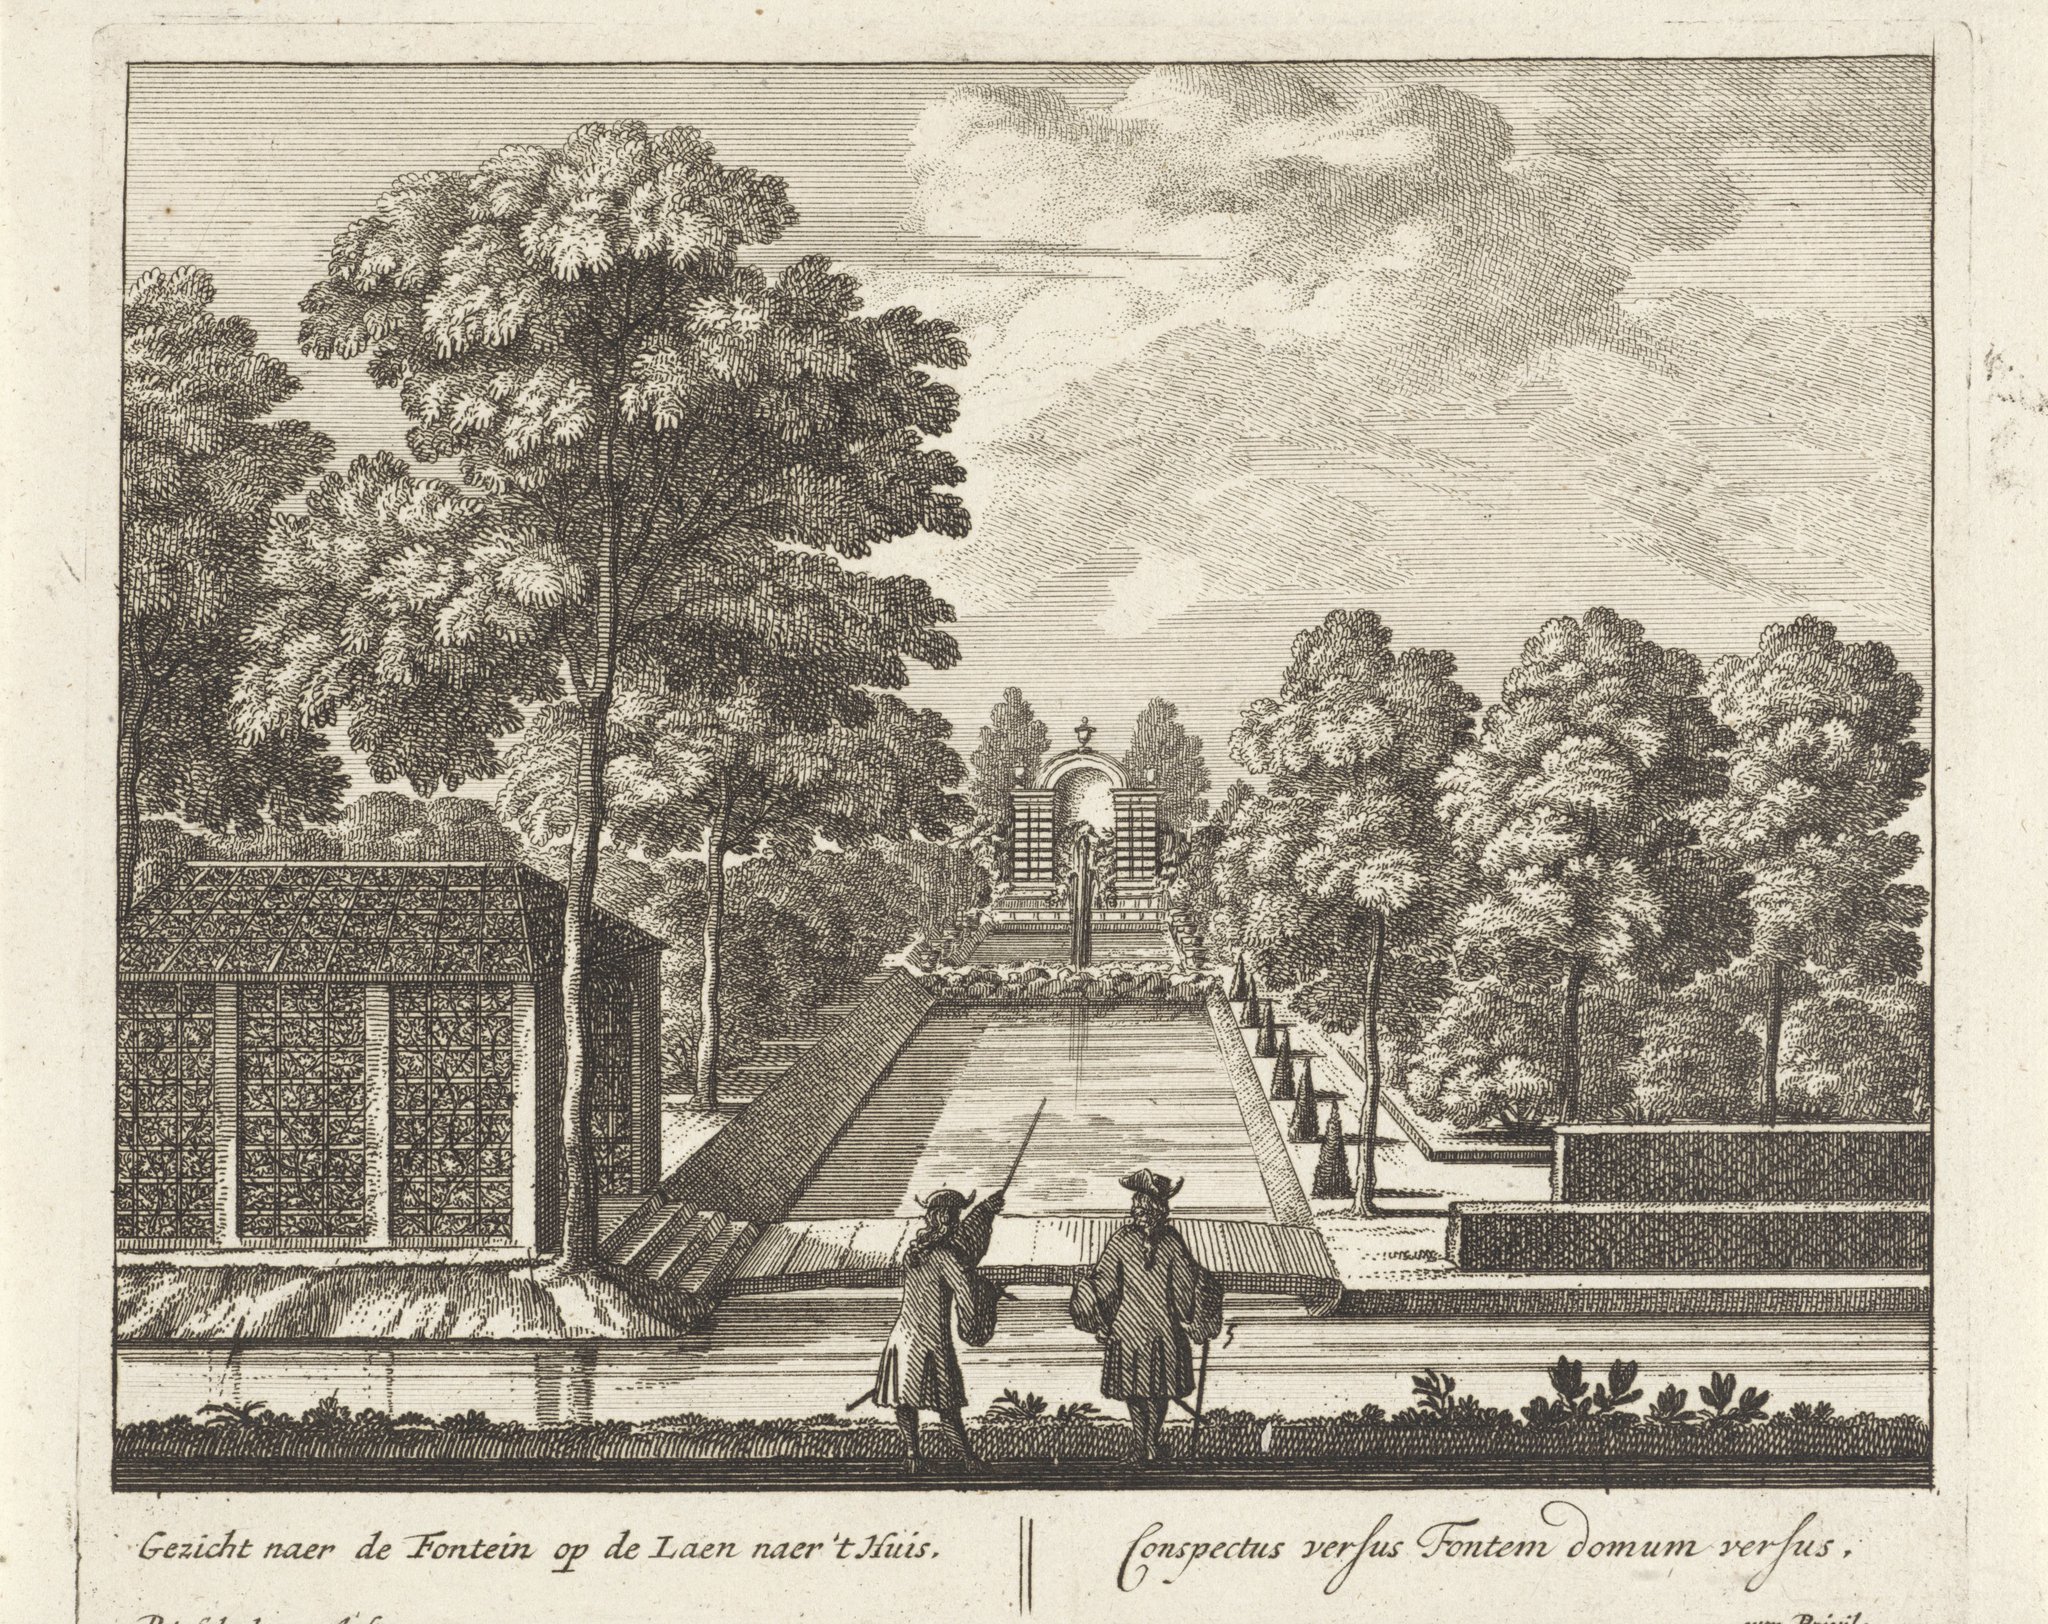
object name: print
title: Gezicht op een fontein vanaf de laan naar Kasteel Rosendael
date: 1675-1711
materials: paper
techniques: etching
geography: amsterdam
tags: garden fountain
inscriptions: collector's mark: Lugt 2228